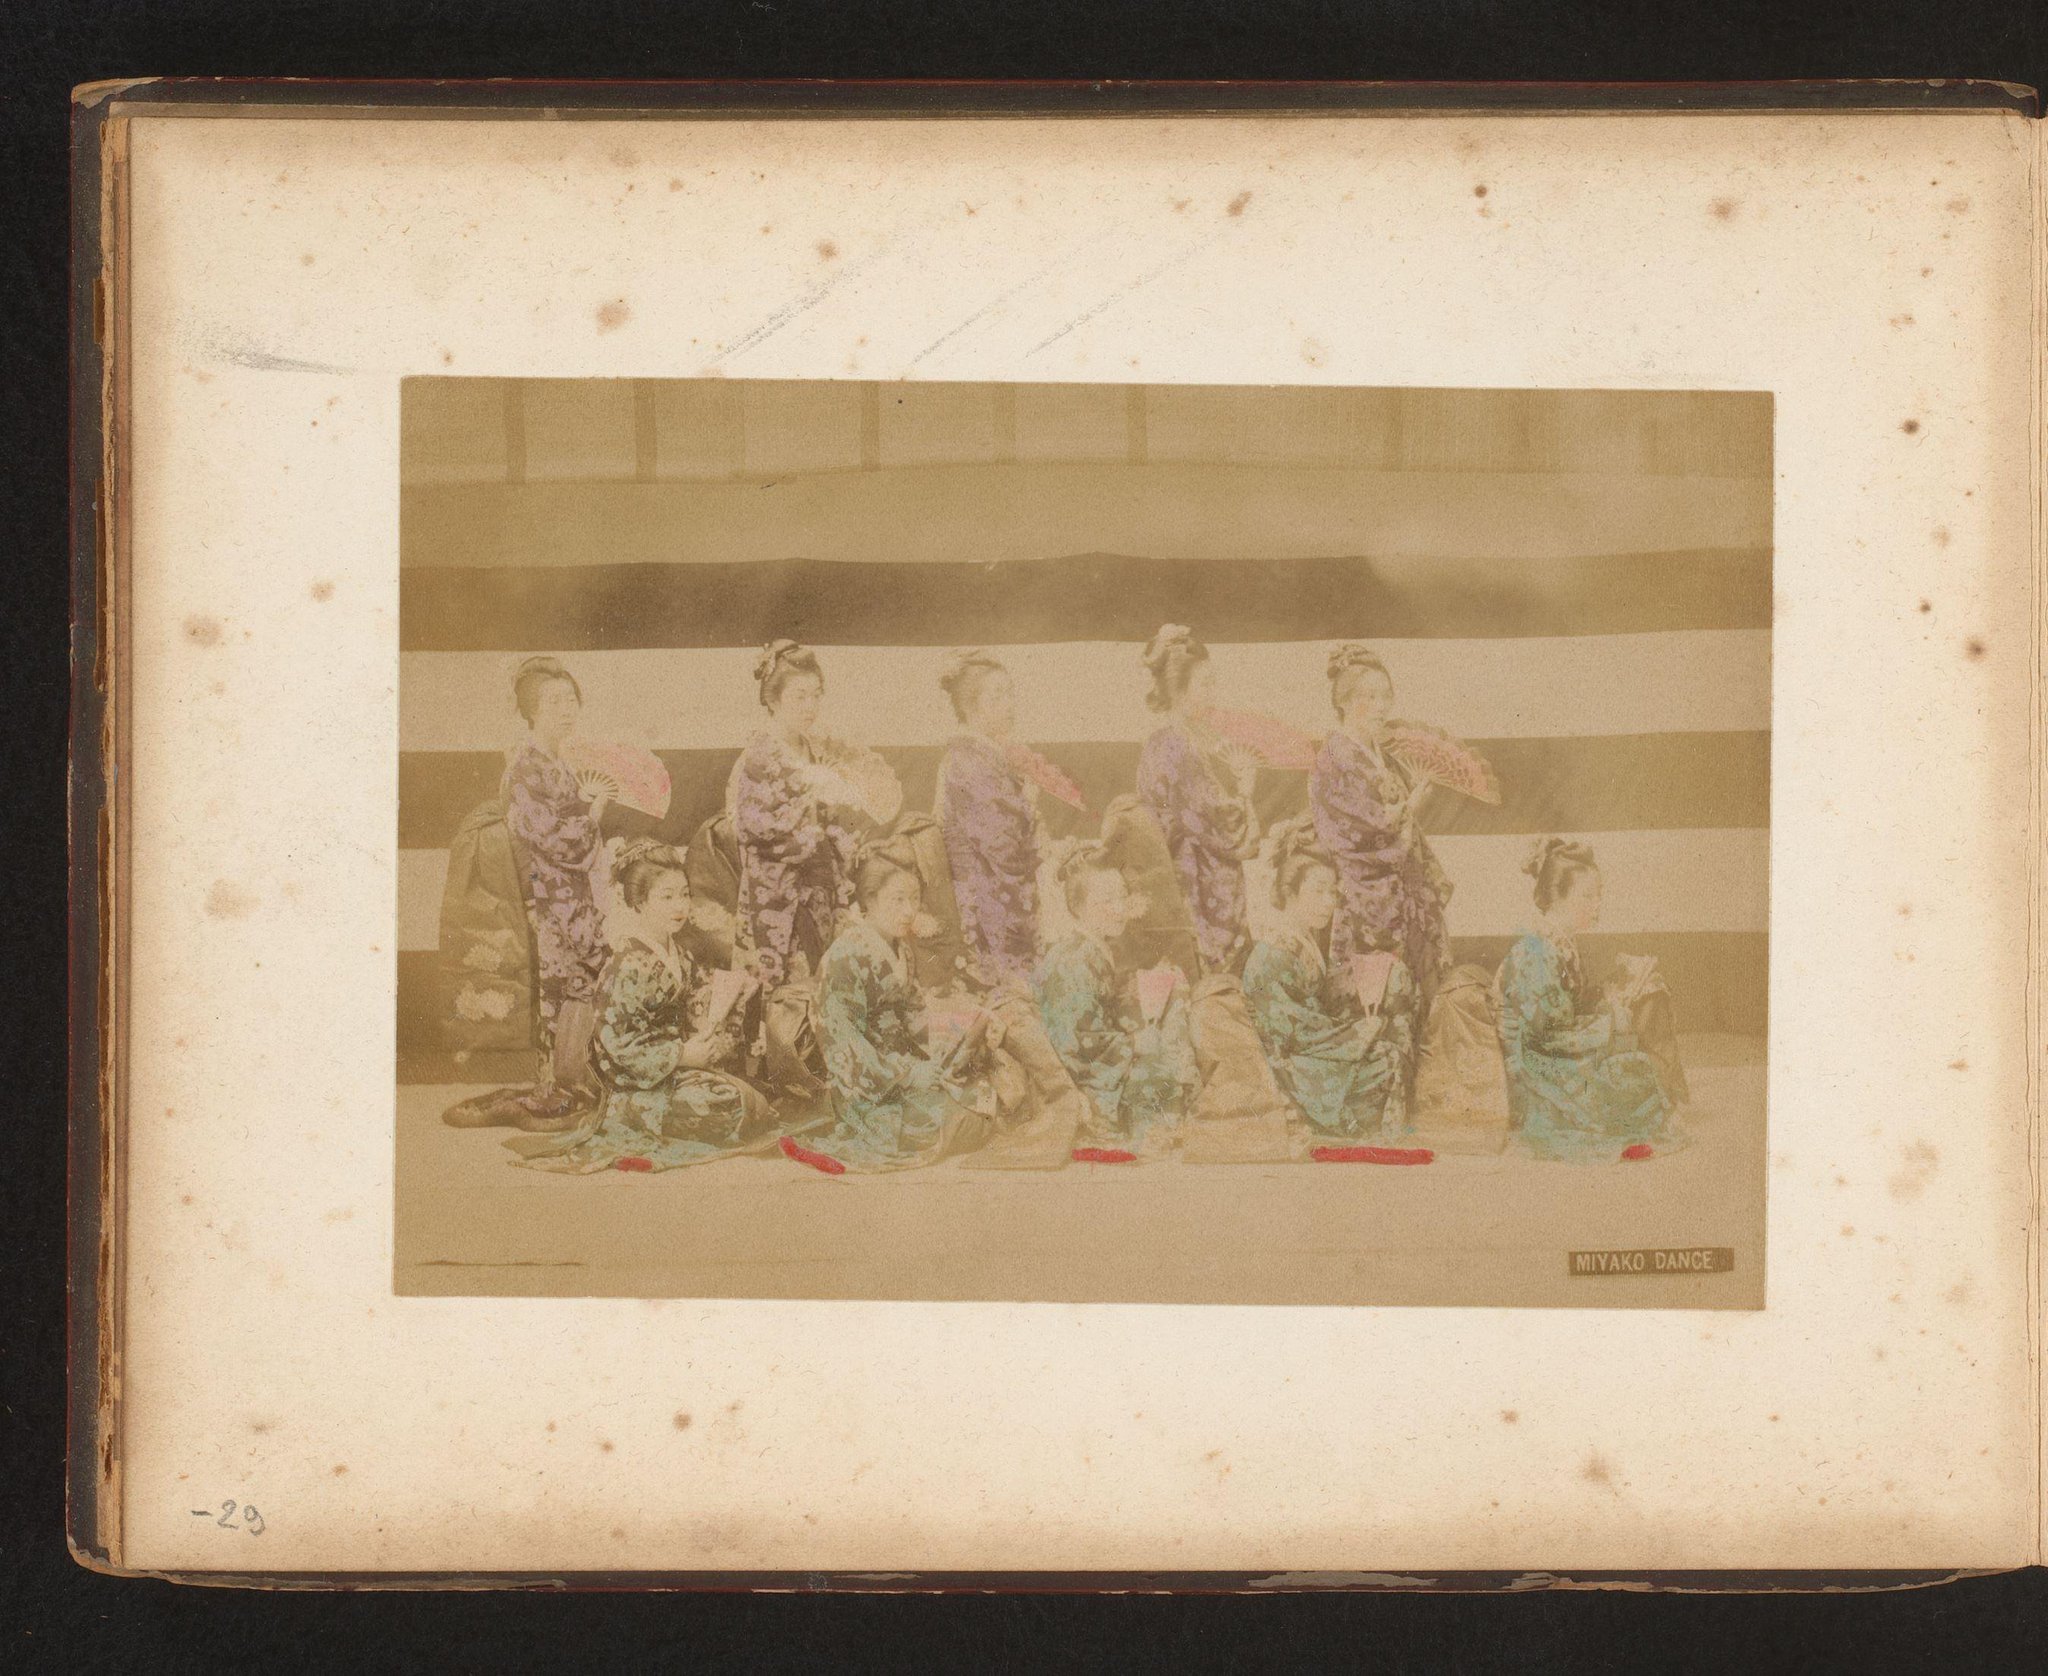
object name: photograph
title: Miyako Odori optreden in Japan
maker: Anonymous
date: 1851-1900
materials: paper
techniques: albumen print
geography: japan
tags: group dancing, japan